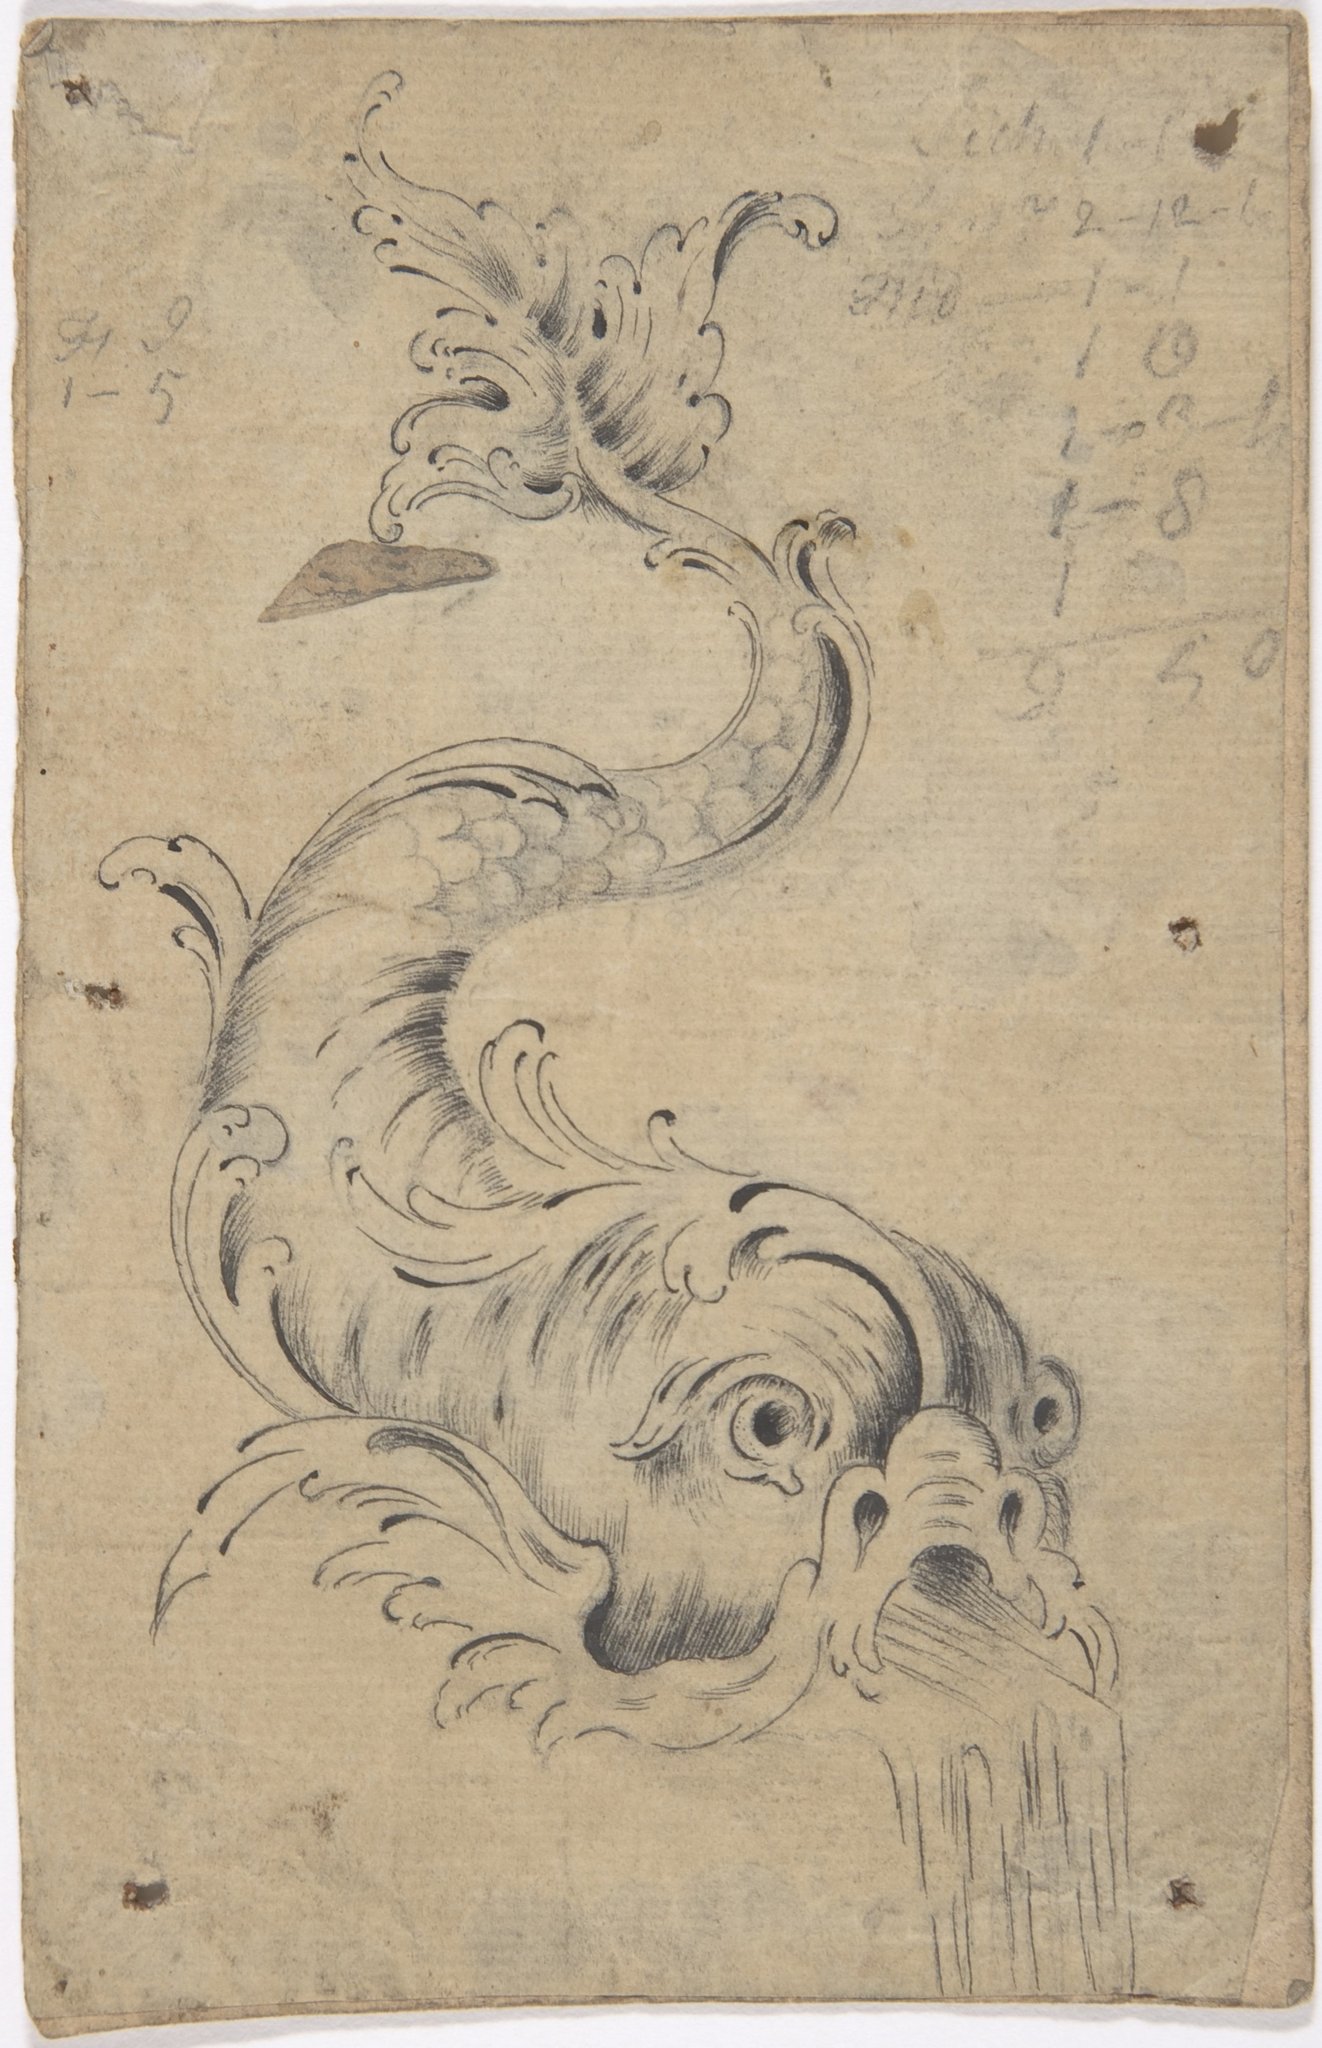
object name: drawing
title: Dolphin Fountain Element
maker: anonymous, british, 18th century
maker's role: artist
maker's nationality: british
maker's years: 1700-1800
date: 1701-1800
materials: ink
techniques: pen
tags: fountains,dolphins